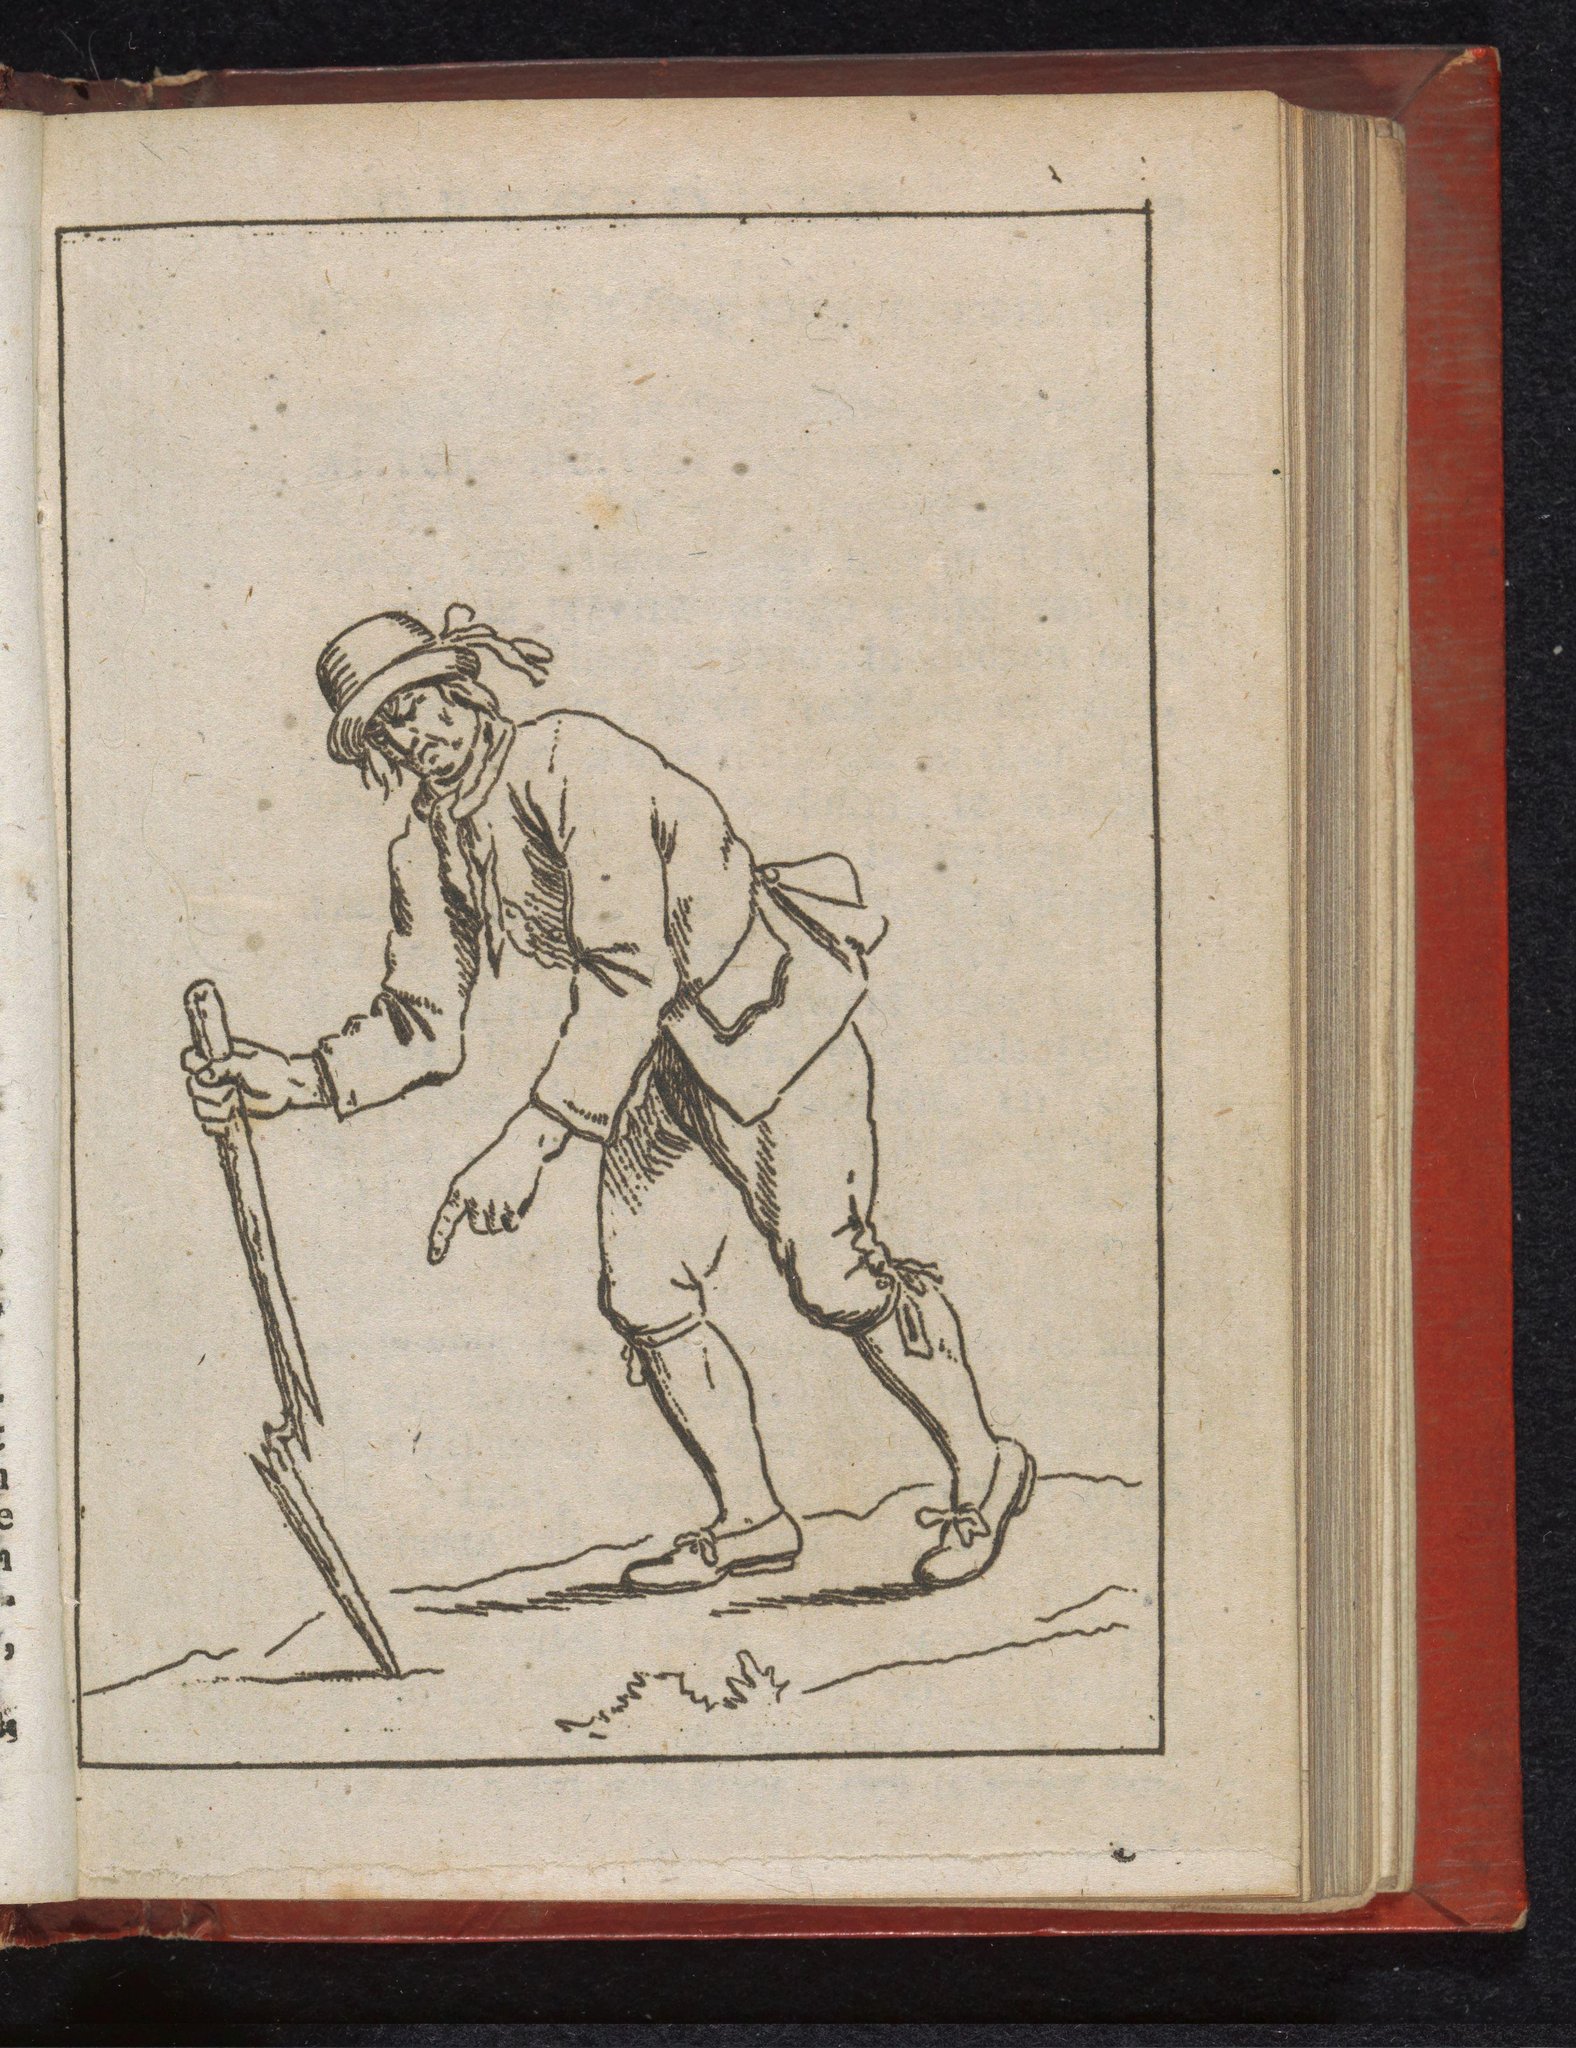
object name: print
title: Voorover vallende man die leunt op een gebroken stok, 1796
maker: pieter van woensel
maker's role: print maker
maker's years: 1747-1808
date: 1795-1796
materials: paper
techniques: etching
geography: netherlands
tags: walking-stick, staff, stumbling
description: Spotprent van een voorover vallende man die leunt op een gebroken stok, 1796. Tegenover blz. 16: 'Over 't aanzien der Republiek der Vereenigde Nederlanden onder de Mogenheden'. Illustratie in Pieter van Woensels almanak 'De Lantaarn voor 1796'.